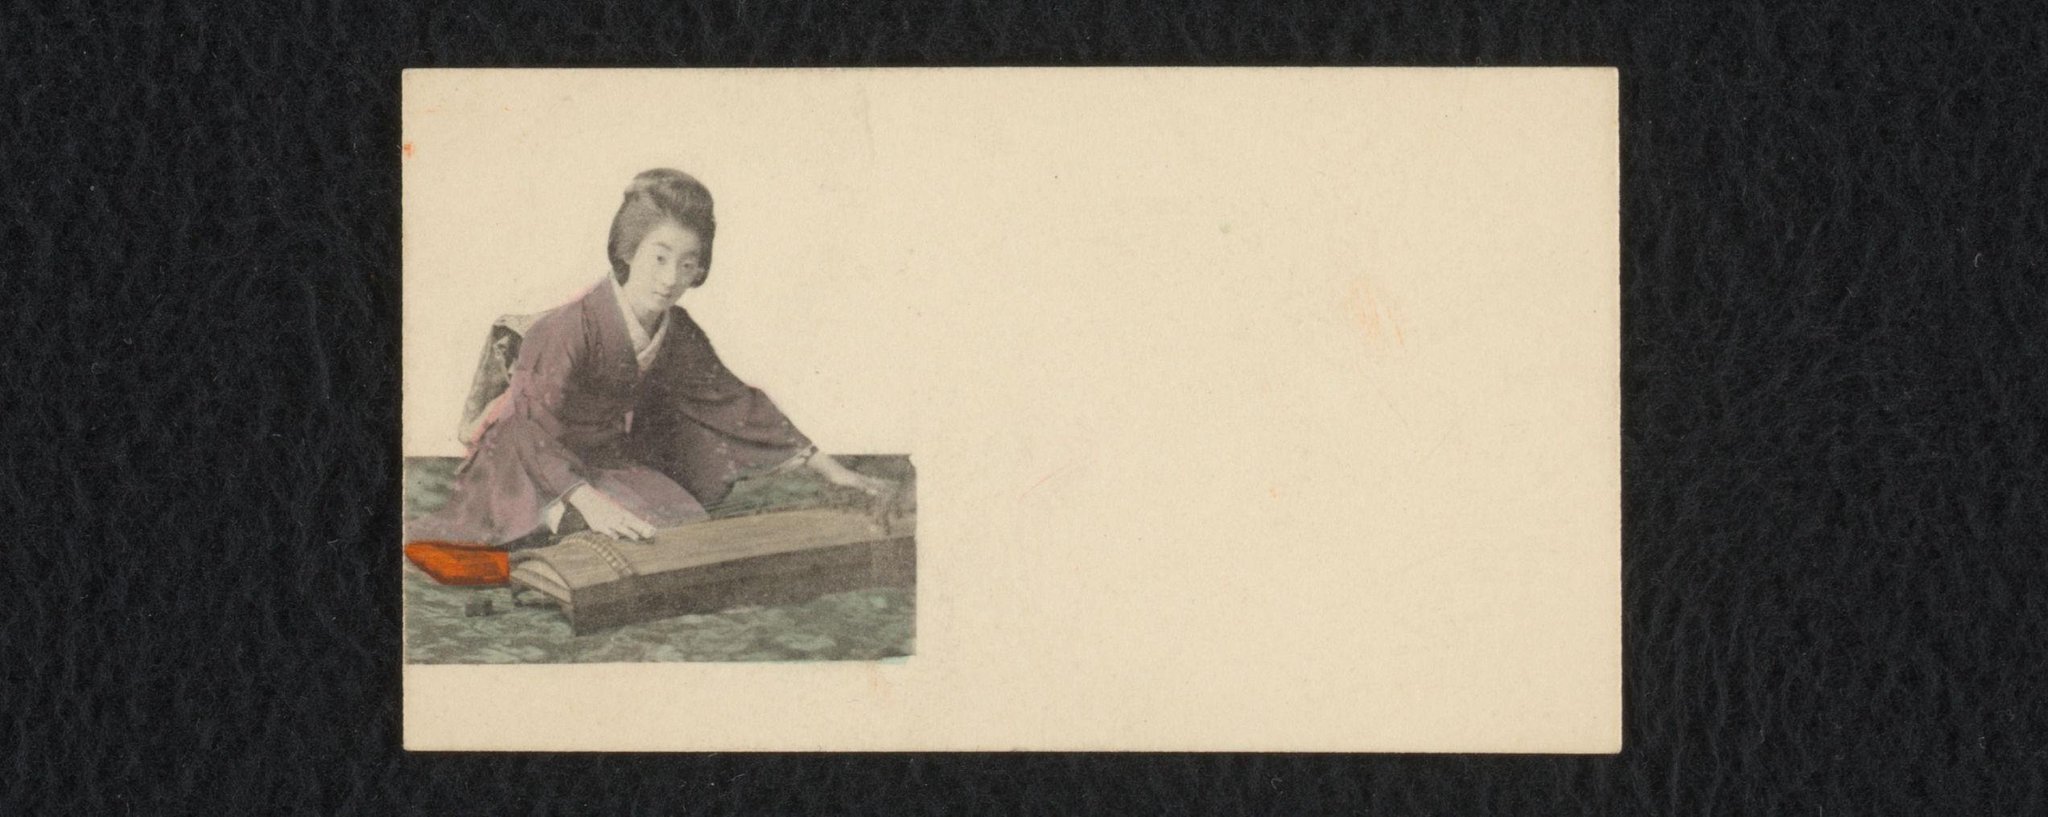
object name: photomechanical print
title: Vrouw bespeelt een koto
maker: Anonymous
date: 1890-1920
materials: paper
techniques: photograph, lithograph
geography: japan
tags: string instruments (plucked), japan